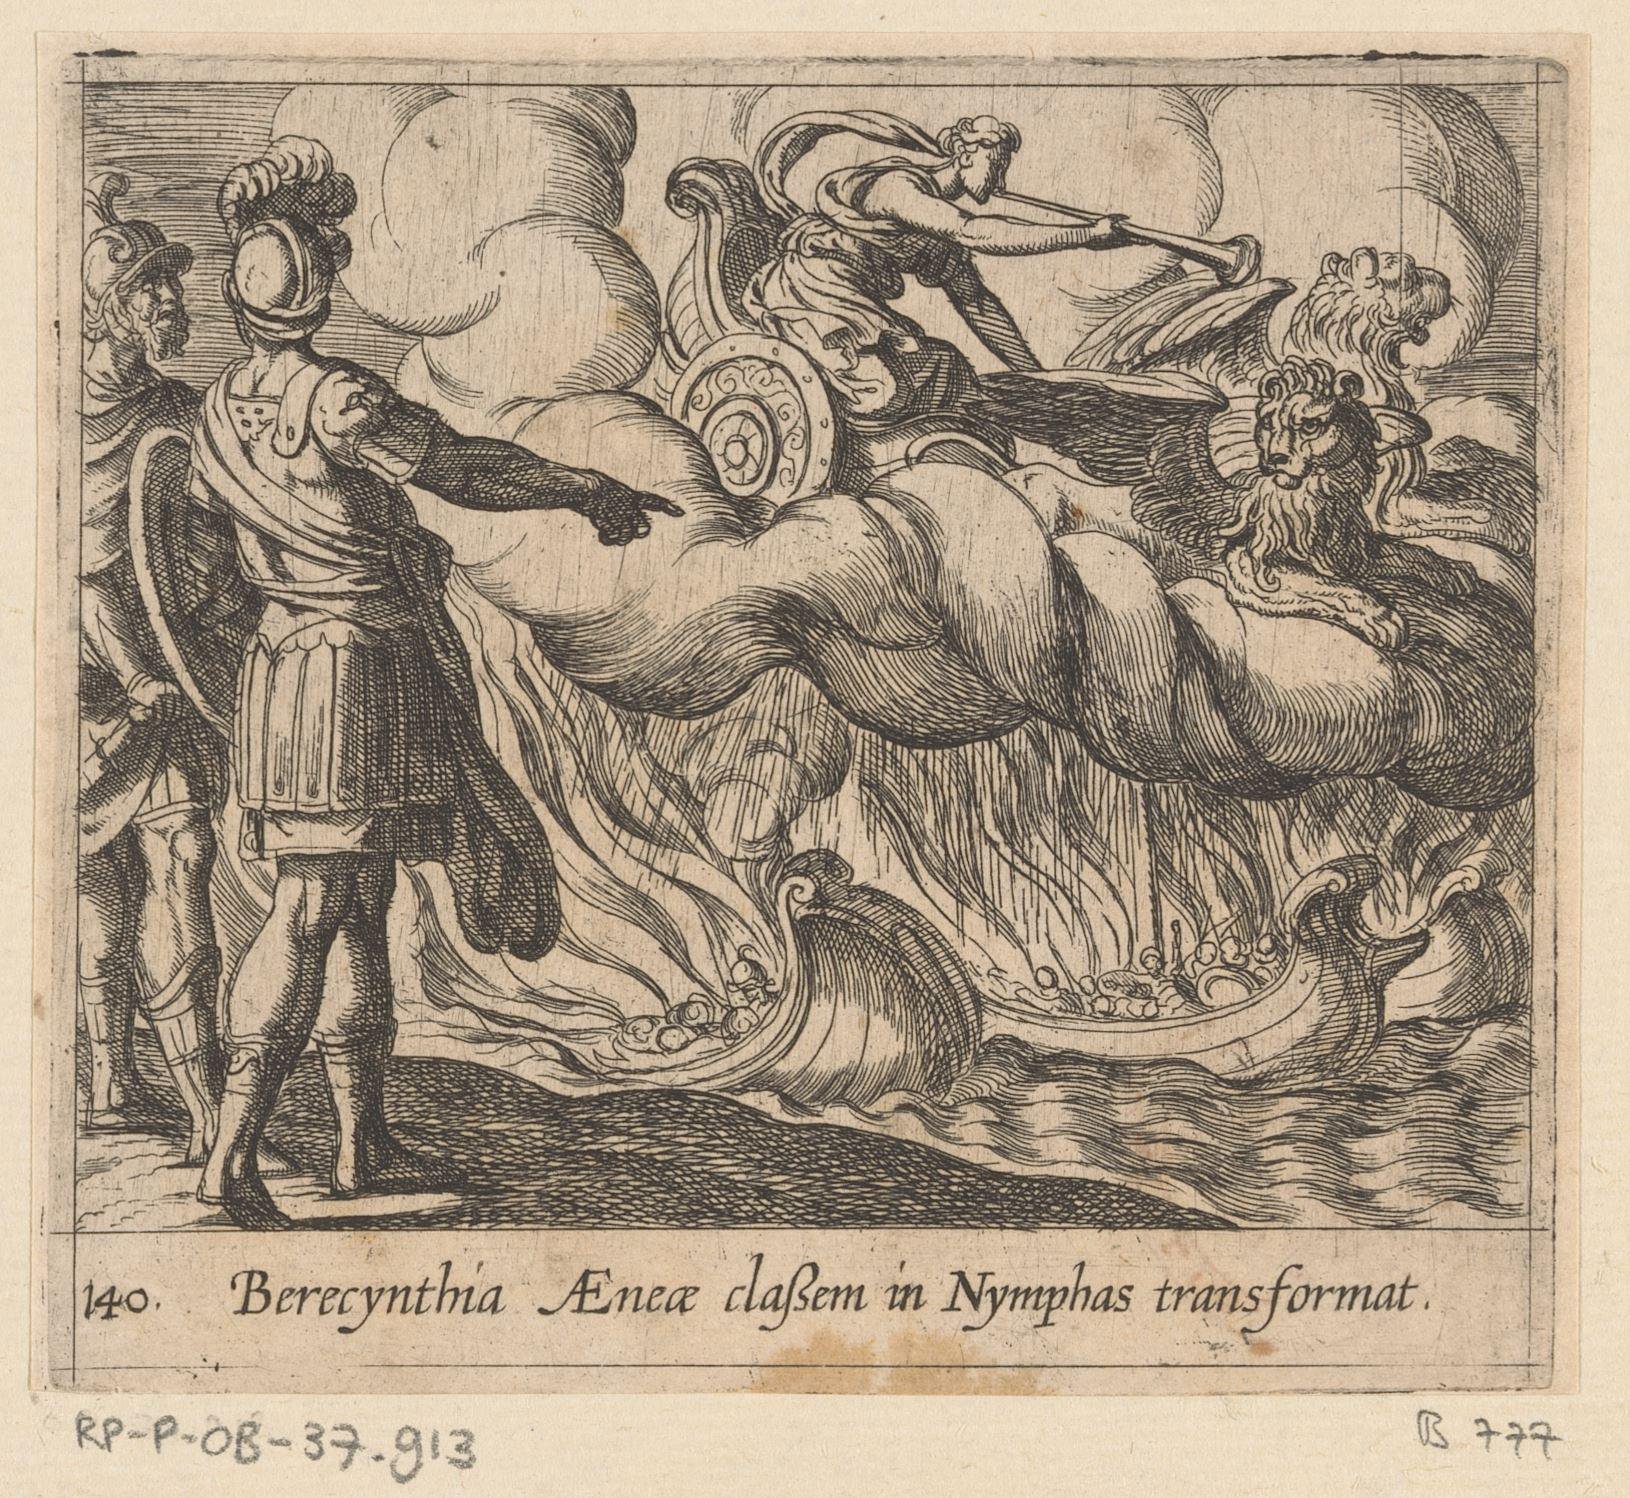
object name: print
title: Metamorphoseon sive transformationum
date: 1606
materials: paper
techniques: etching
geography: antwerp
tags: when turnus sets the trojan ships on fire they turn into sea-nymphs at cybele's request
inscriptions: collector's mark: Lugt 240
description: Als Turnus de Trojaanse schepen in brand steekt, veranderen ze op verzoek van Cybele in nimfen. Titel in het Latijn in ondermarge.